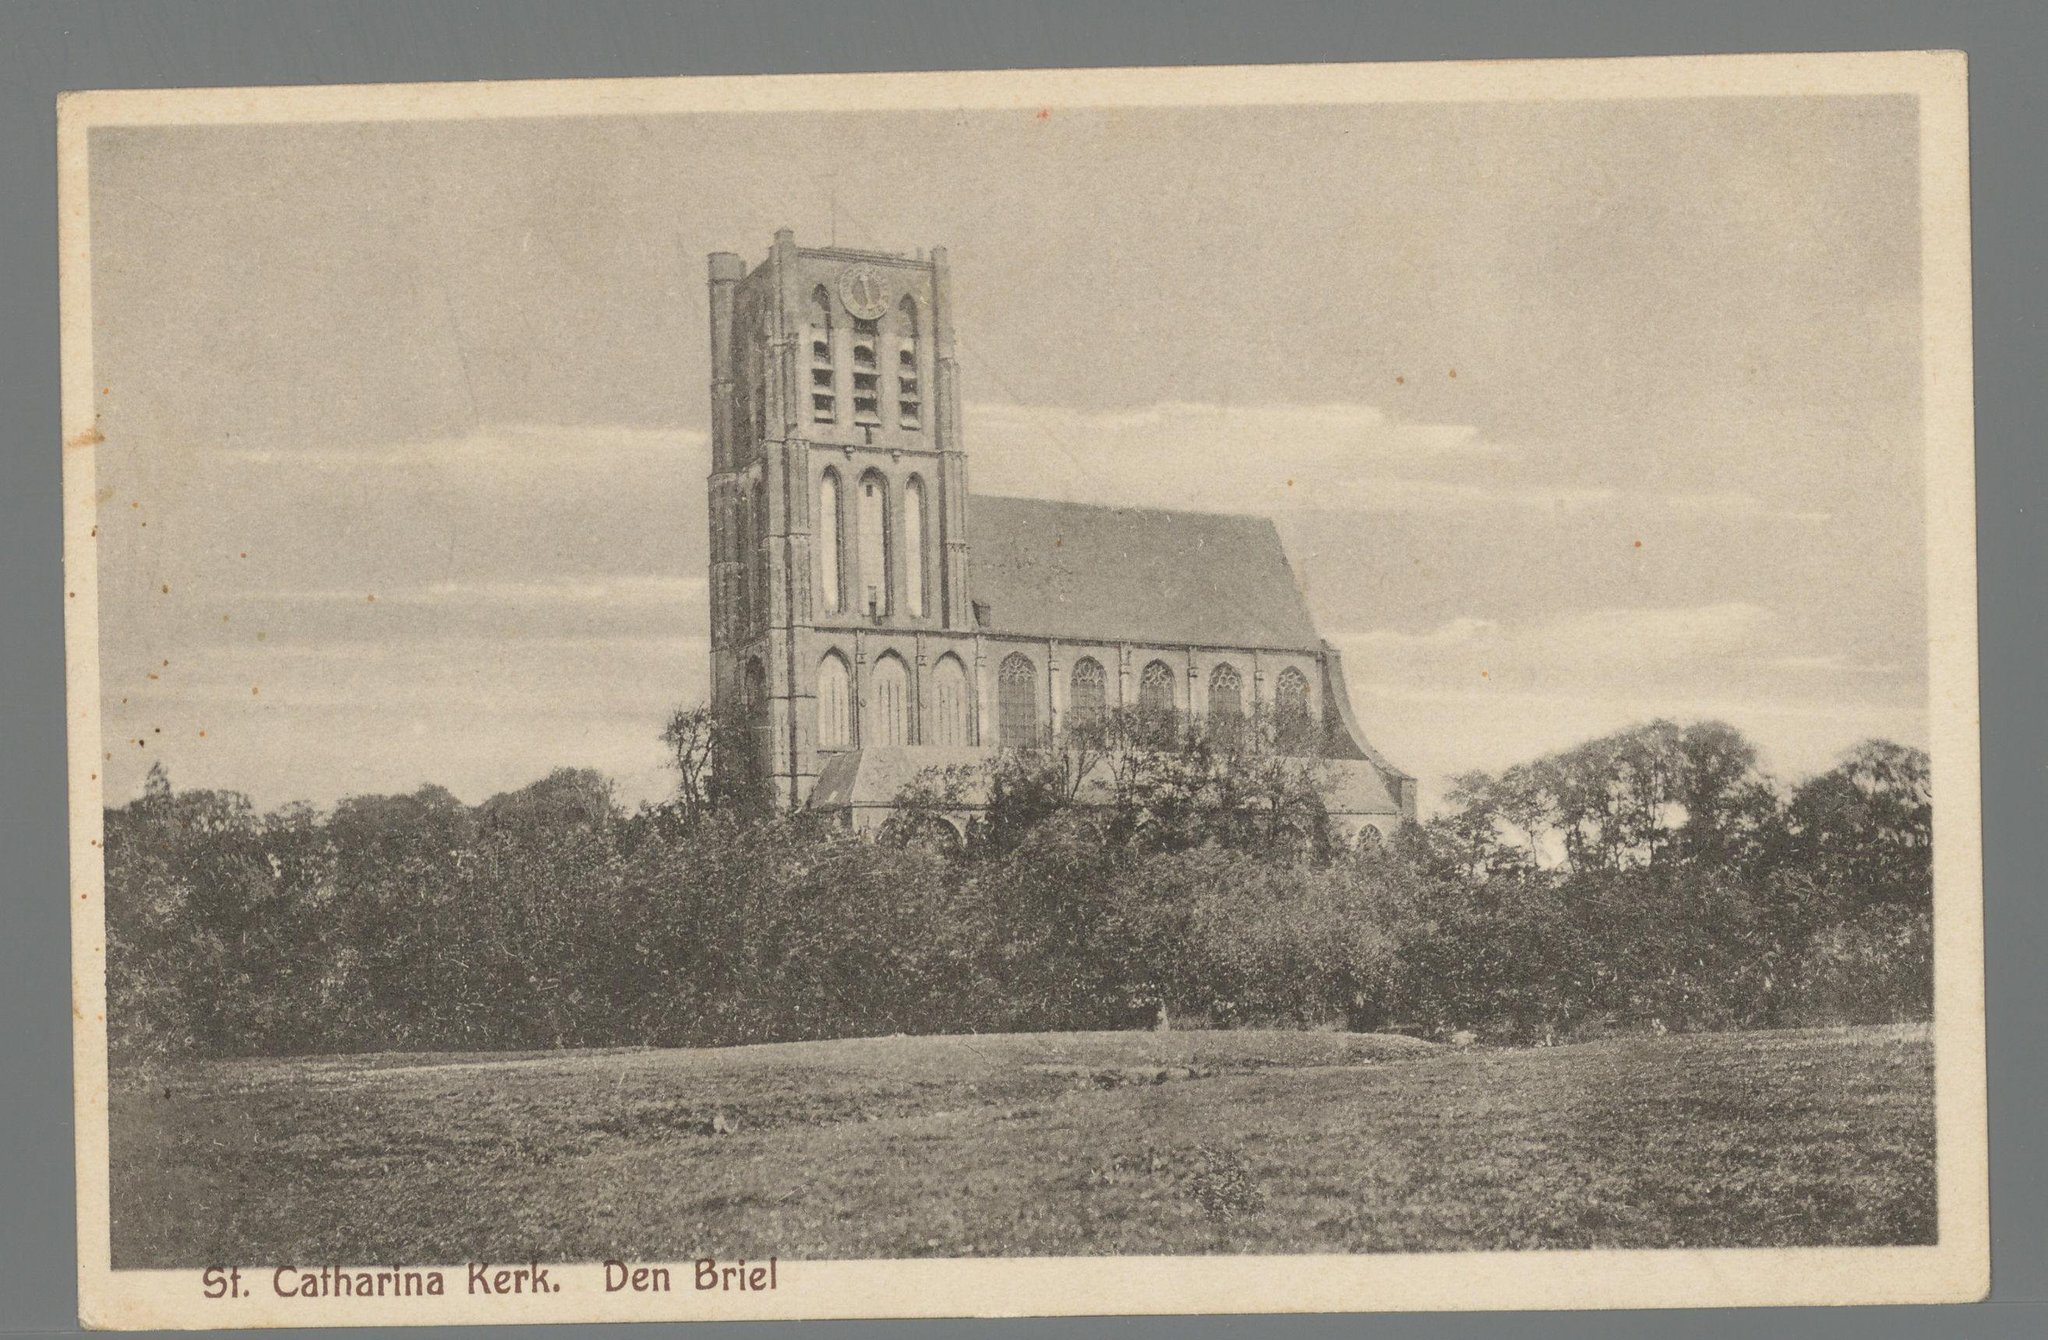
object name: ansichtkaart, prentbriefkaart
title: St. Catharina Kerk. Den Briel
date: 1930-1935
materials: cardboard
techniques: photograph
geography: brielle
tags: church (exterior)